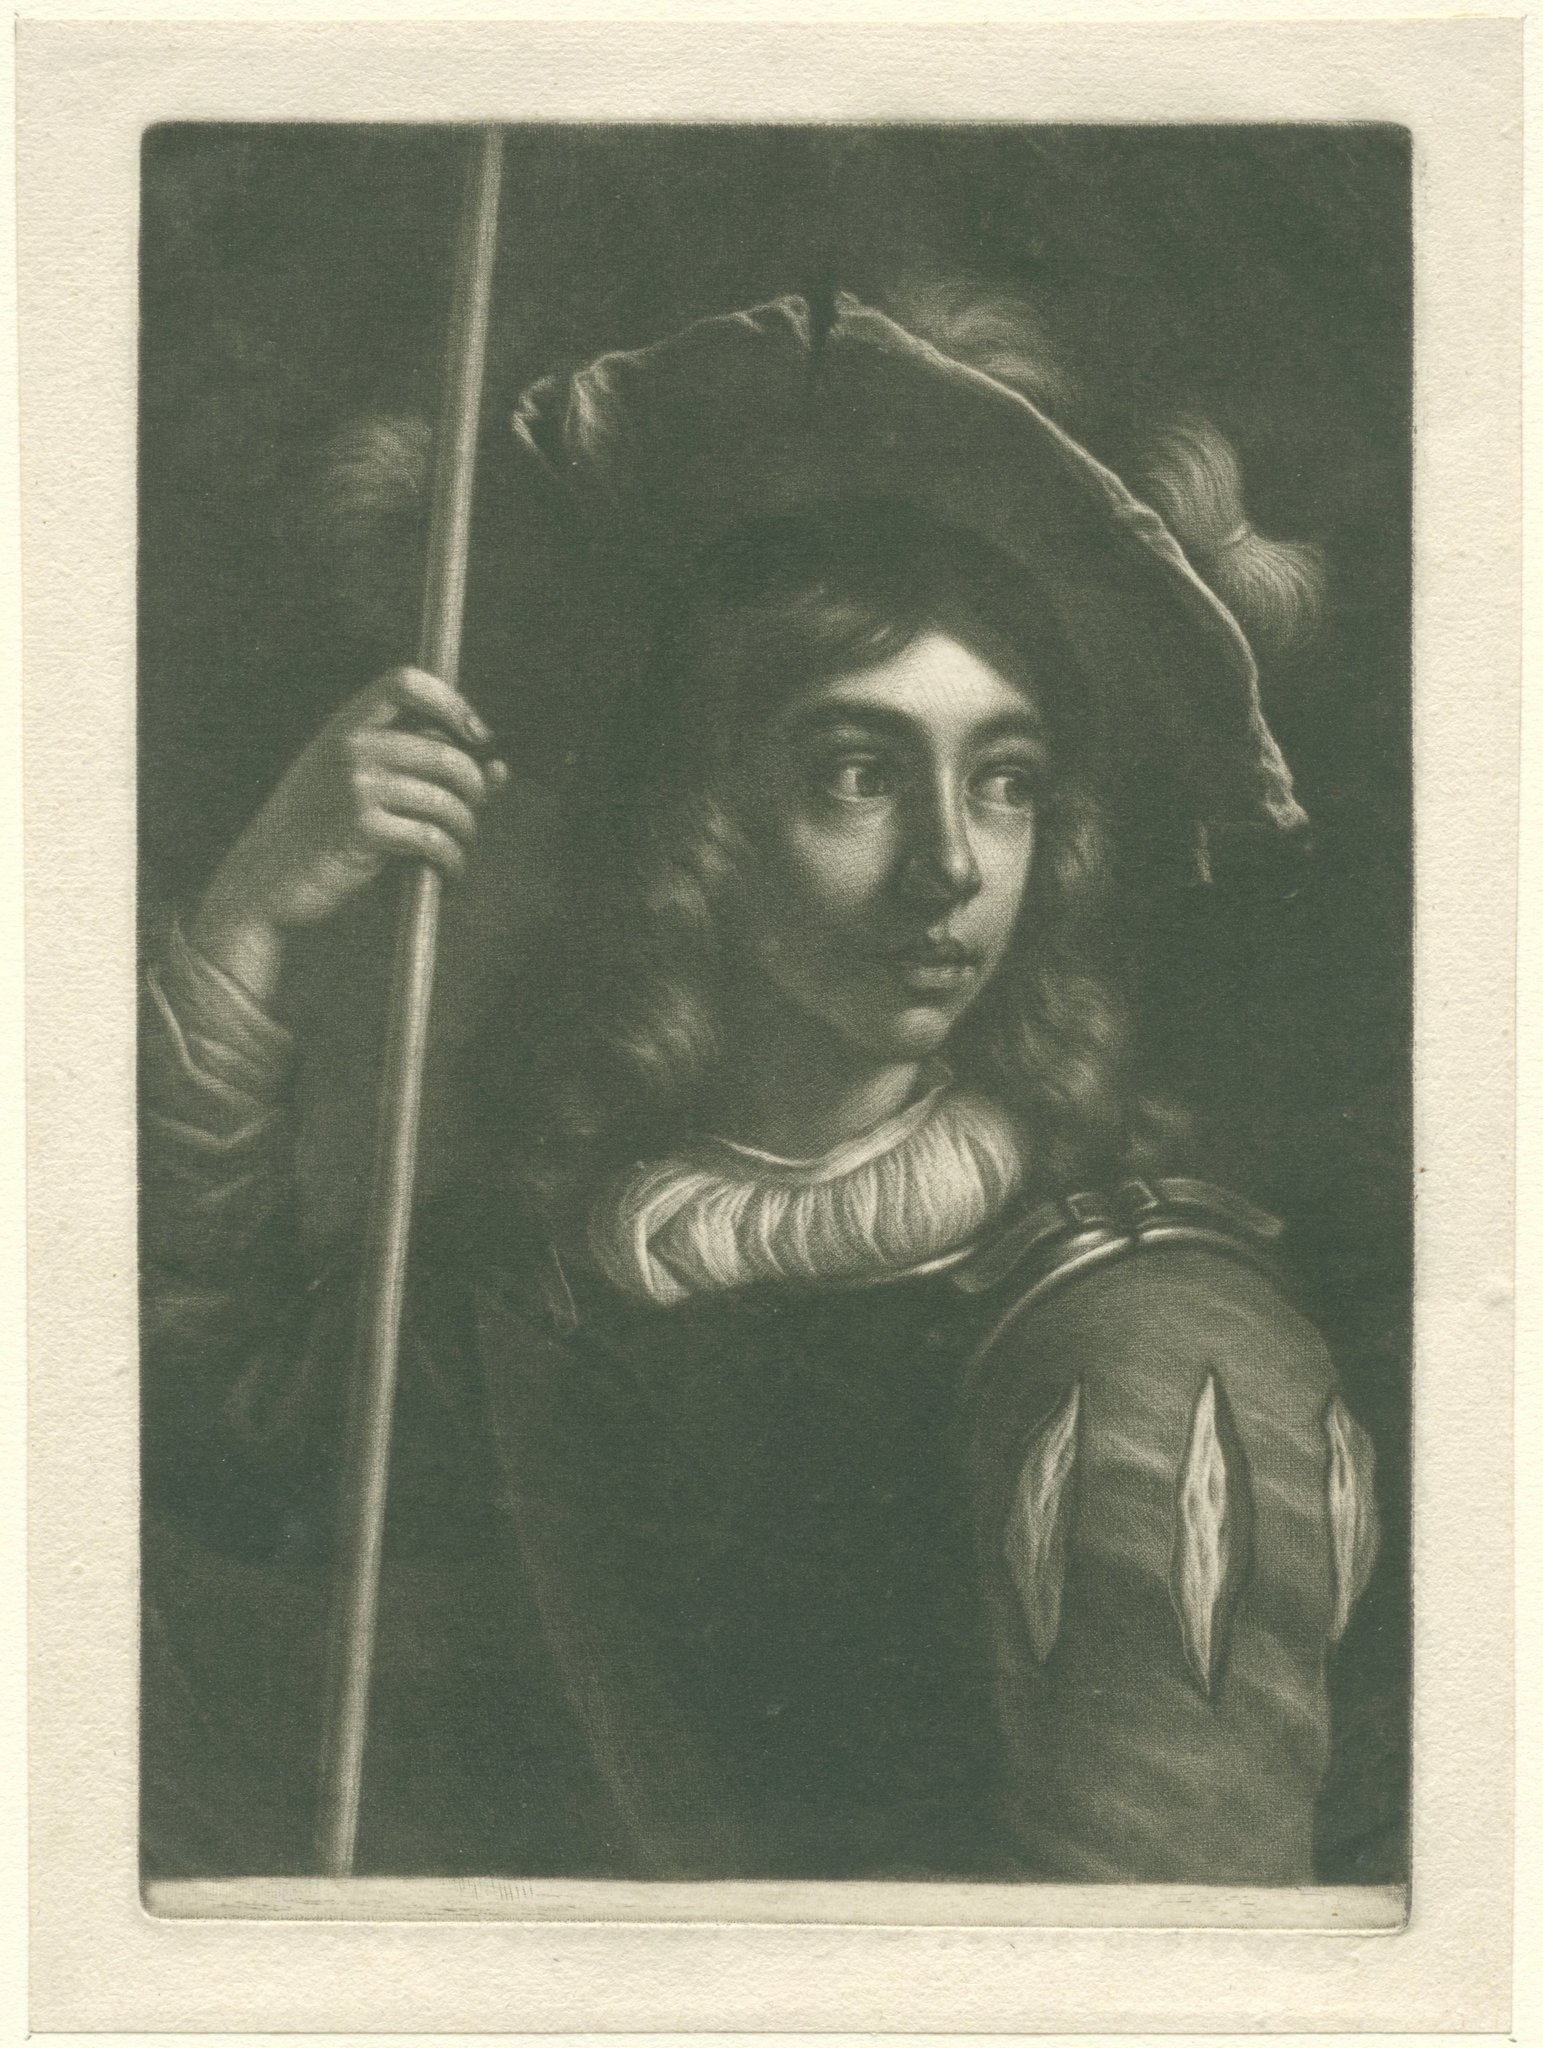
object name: print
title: Vaandeldrager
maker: wallerant vaillant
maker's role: draughtsman, painter, print maker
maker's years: 1623-1677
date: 1658-1677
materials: paper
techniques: mezzotint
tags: standard-bearer, flag-bearer, head-gear: hat (+ men's clothes)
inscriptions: collector's mark: Lugt 2228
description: Een jonge vaandeldrager met een gevederde hoed.